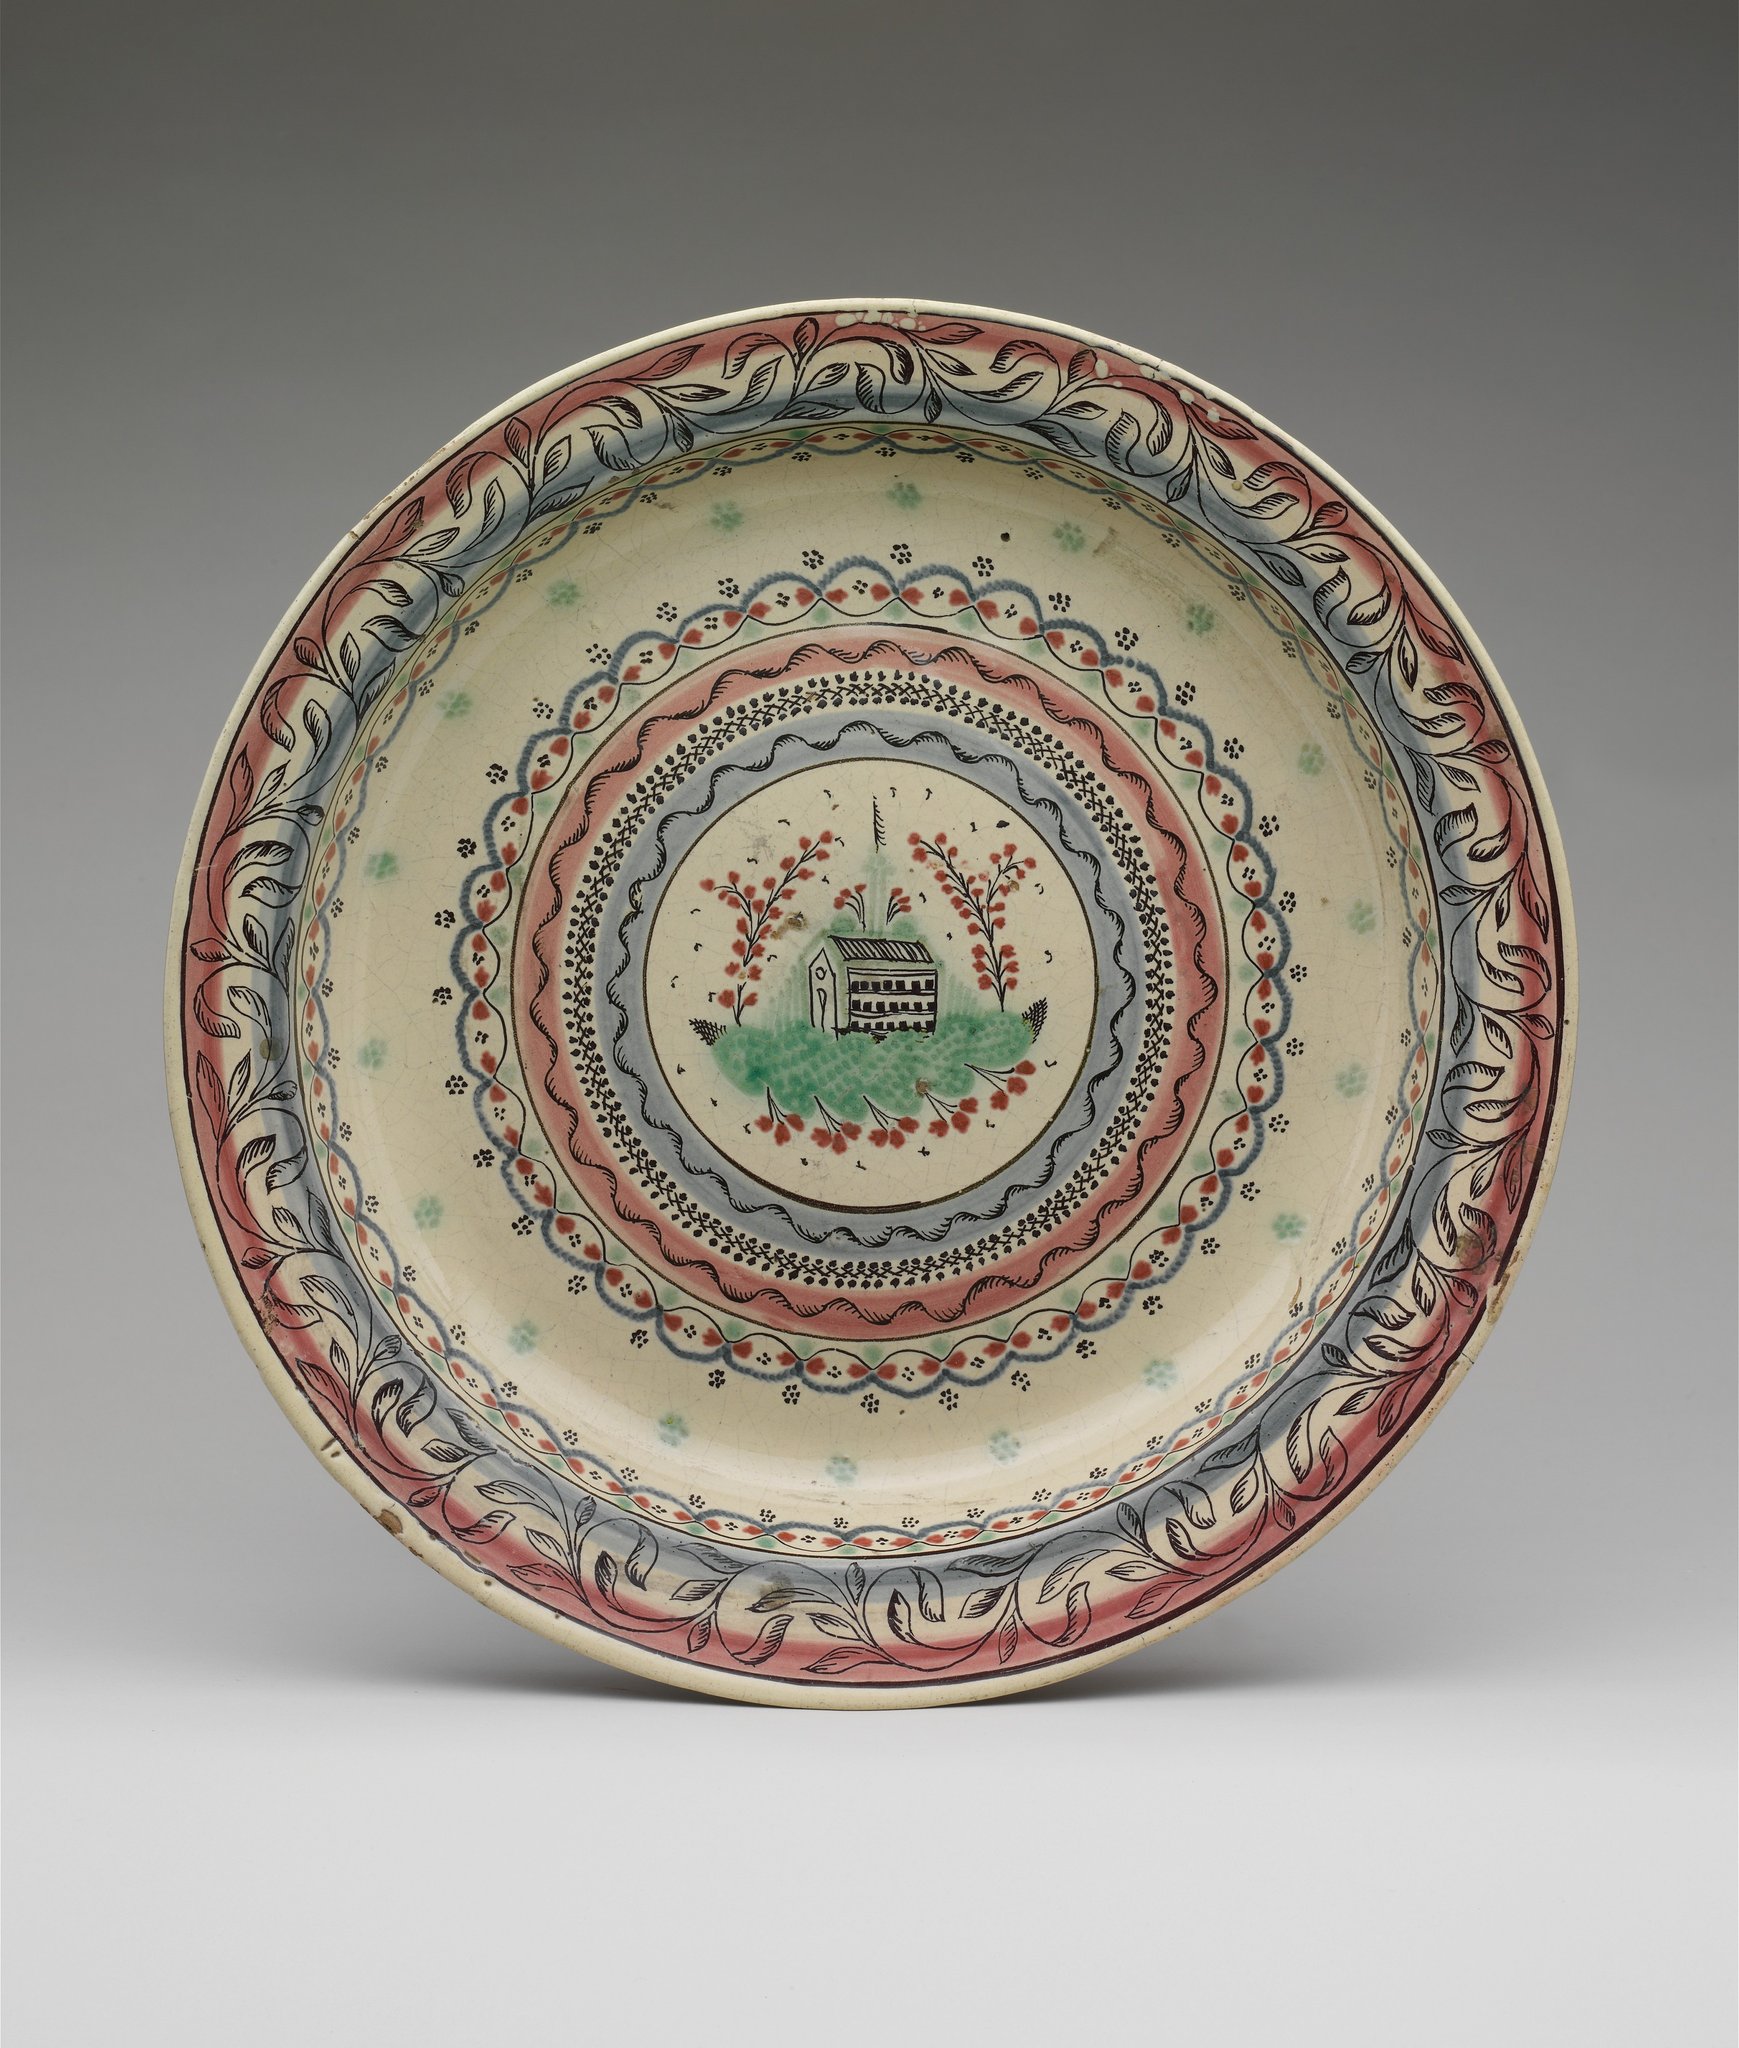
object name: plate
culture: mexican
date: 1825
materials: earthenware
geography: mexico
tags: houses